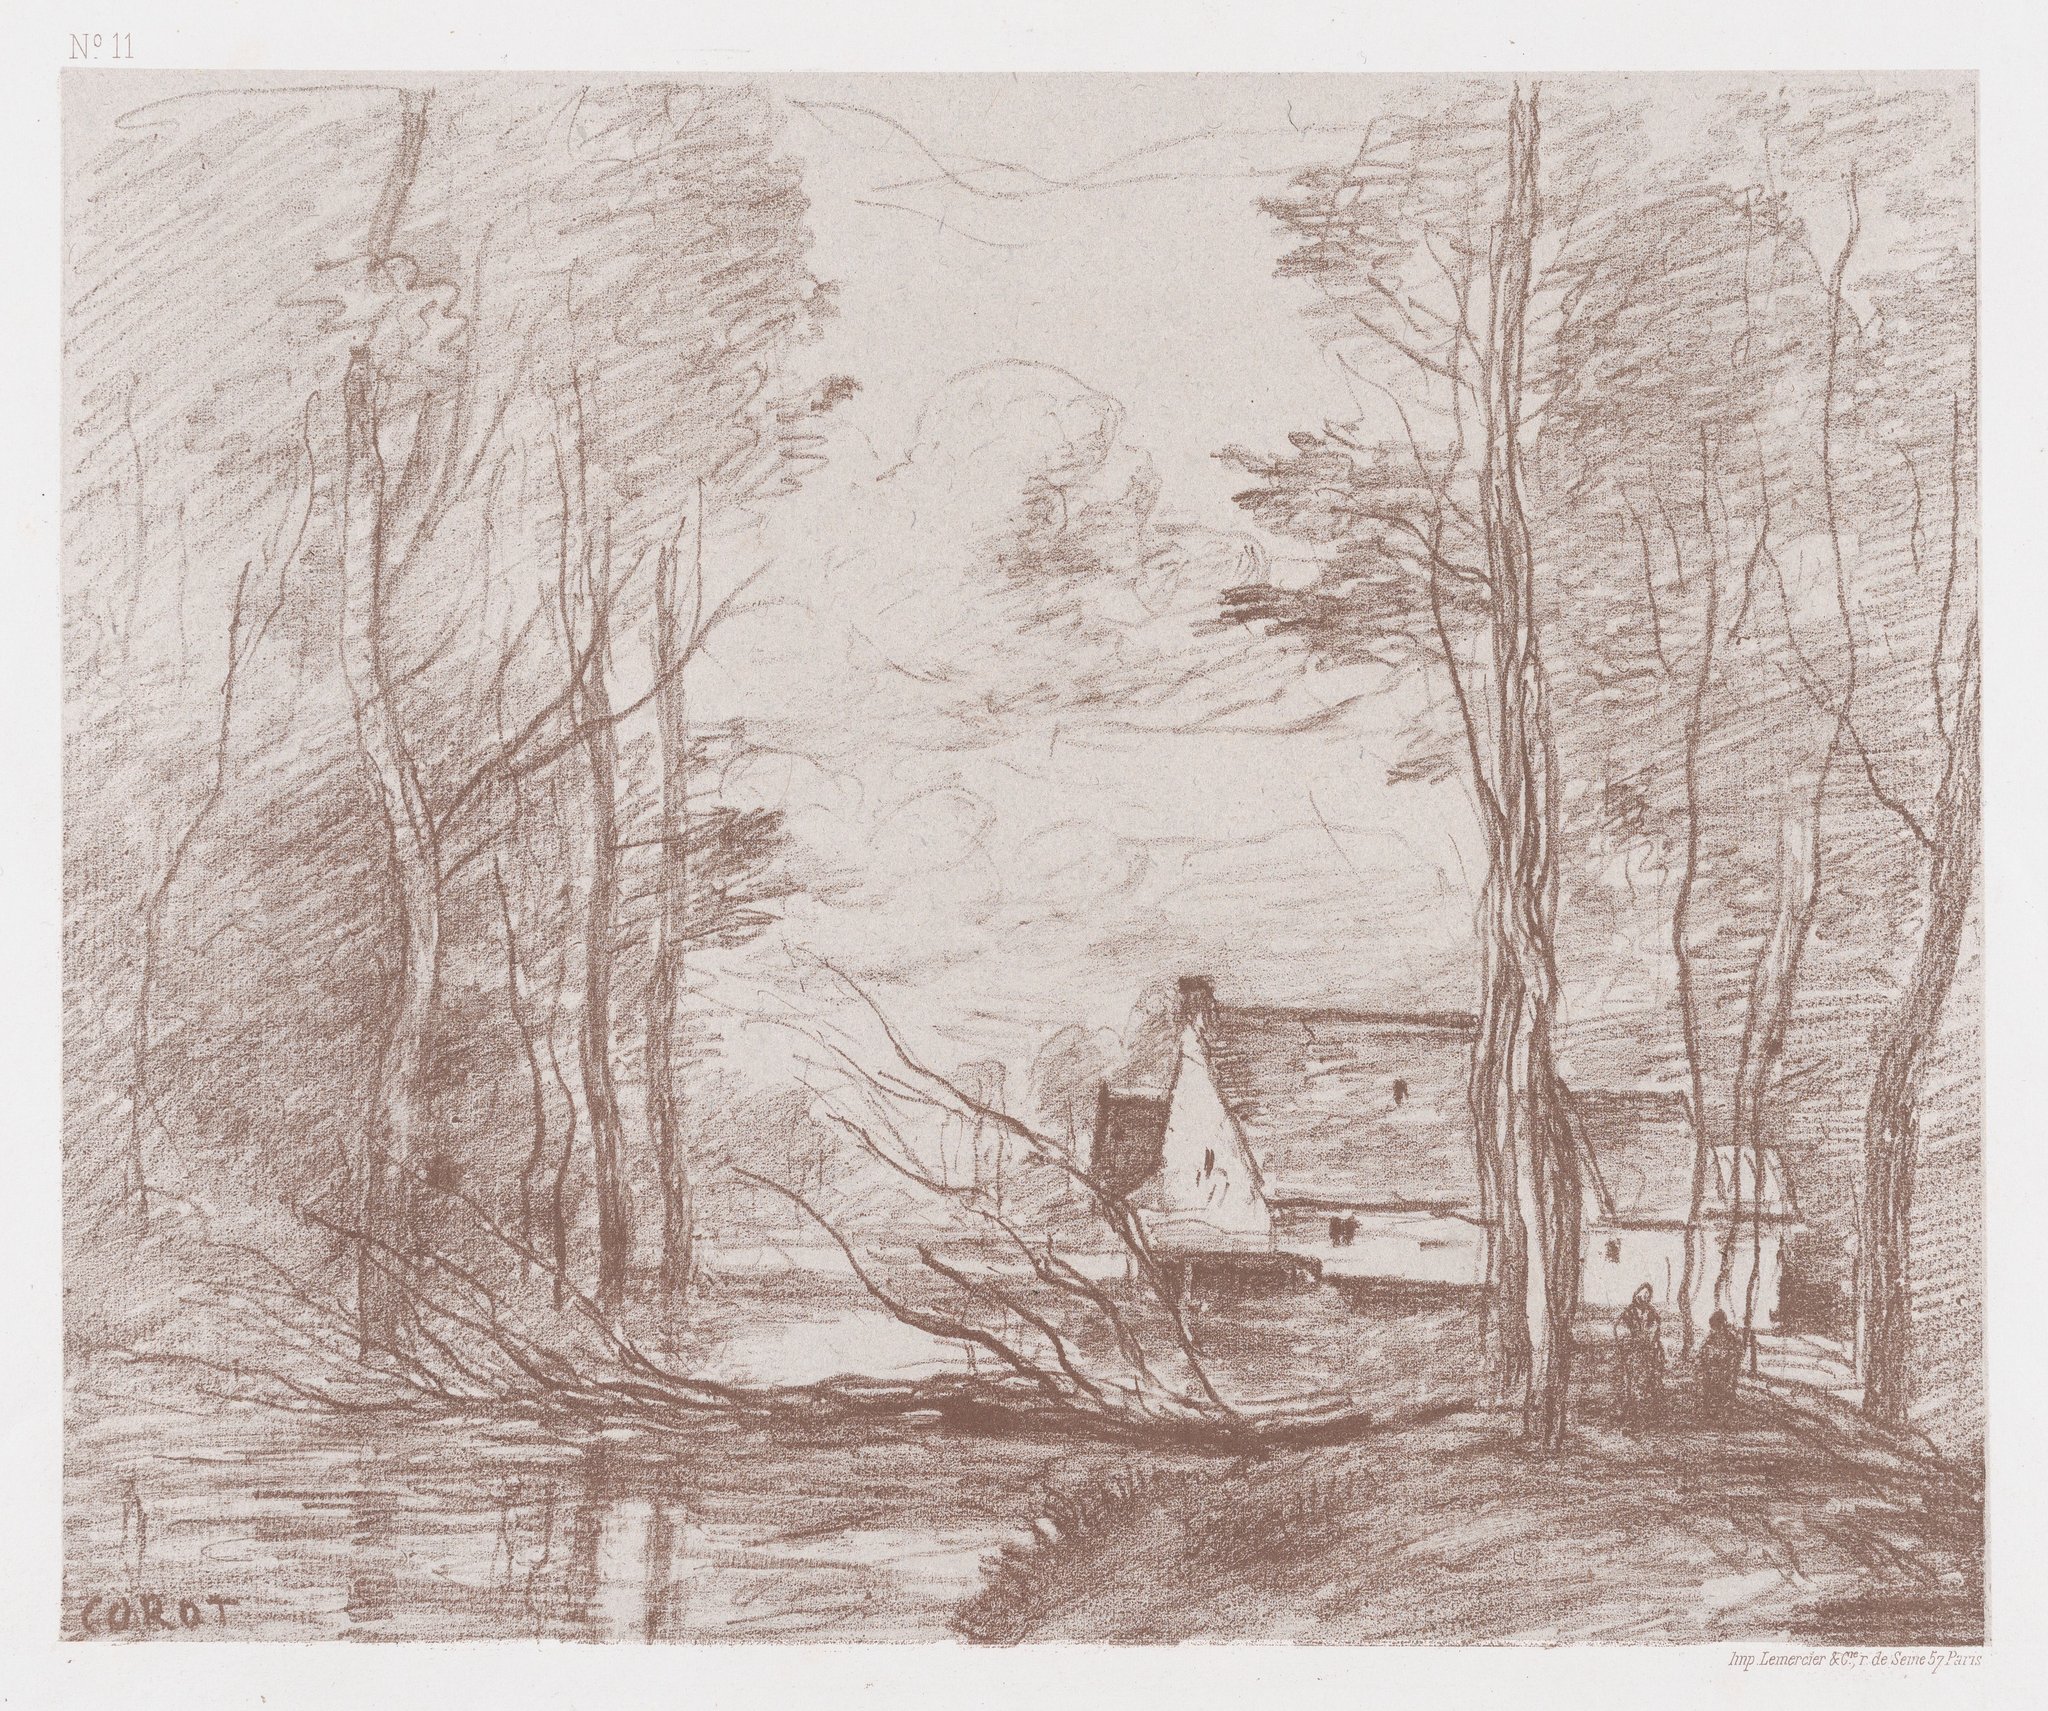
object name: print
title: The Mill at Cuincy, Near Douai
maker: jean-baptiste-camille corot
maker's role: artist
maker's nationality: french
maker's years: 1796-1875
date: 1871-1872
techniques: lithography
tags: watermills,trees